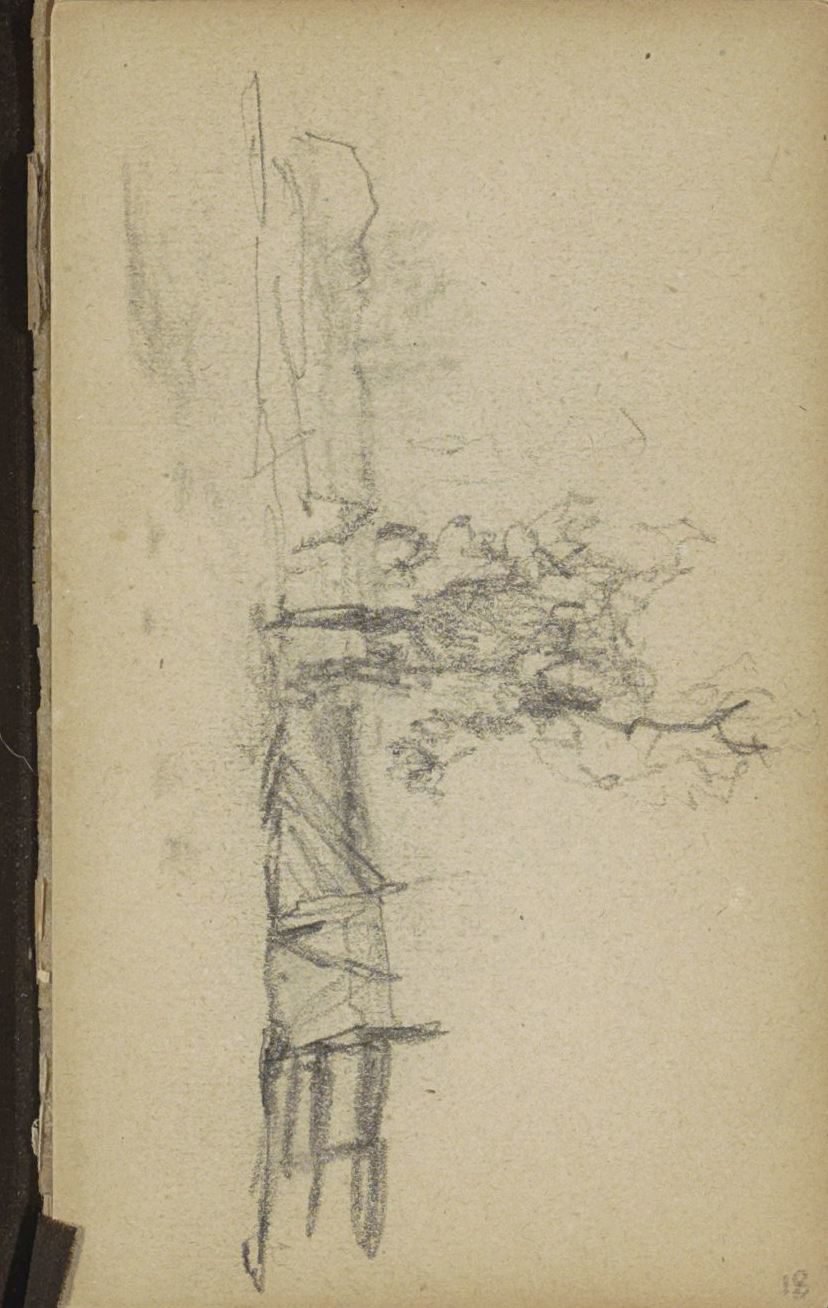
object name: sketchbook leaf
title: Hek en boom in een weiland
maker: johan hendrik weissenbruch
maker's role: draughtsman, painter, print maker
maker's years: 1824-1903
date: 1834-1903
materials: paper, pencil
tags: fence, wall, paling, meadow, pasture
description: Blad 18 recto uit een schetsboek met 32 bladen.